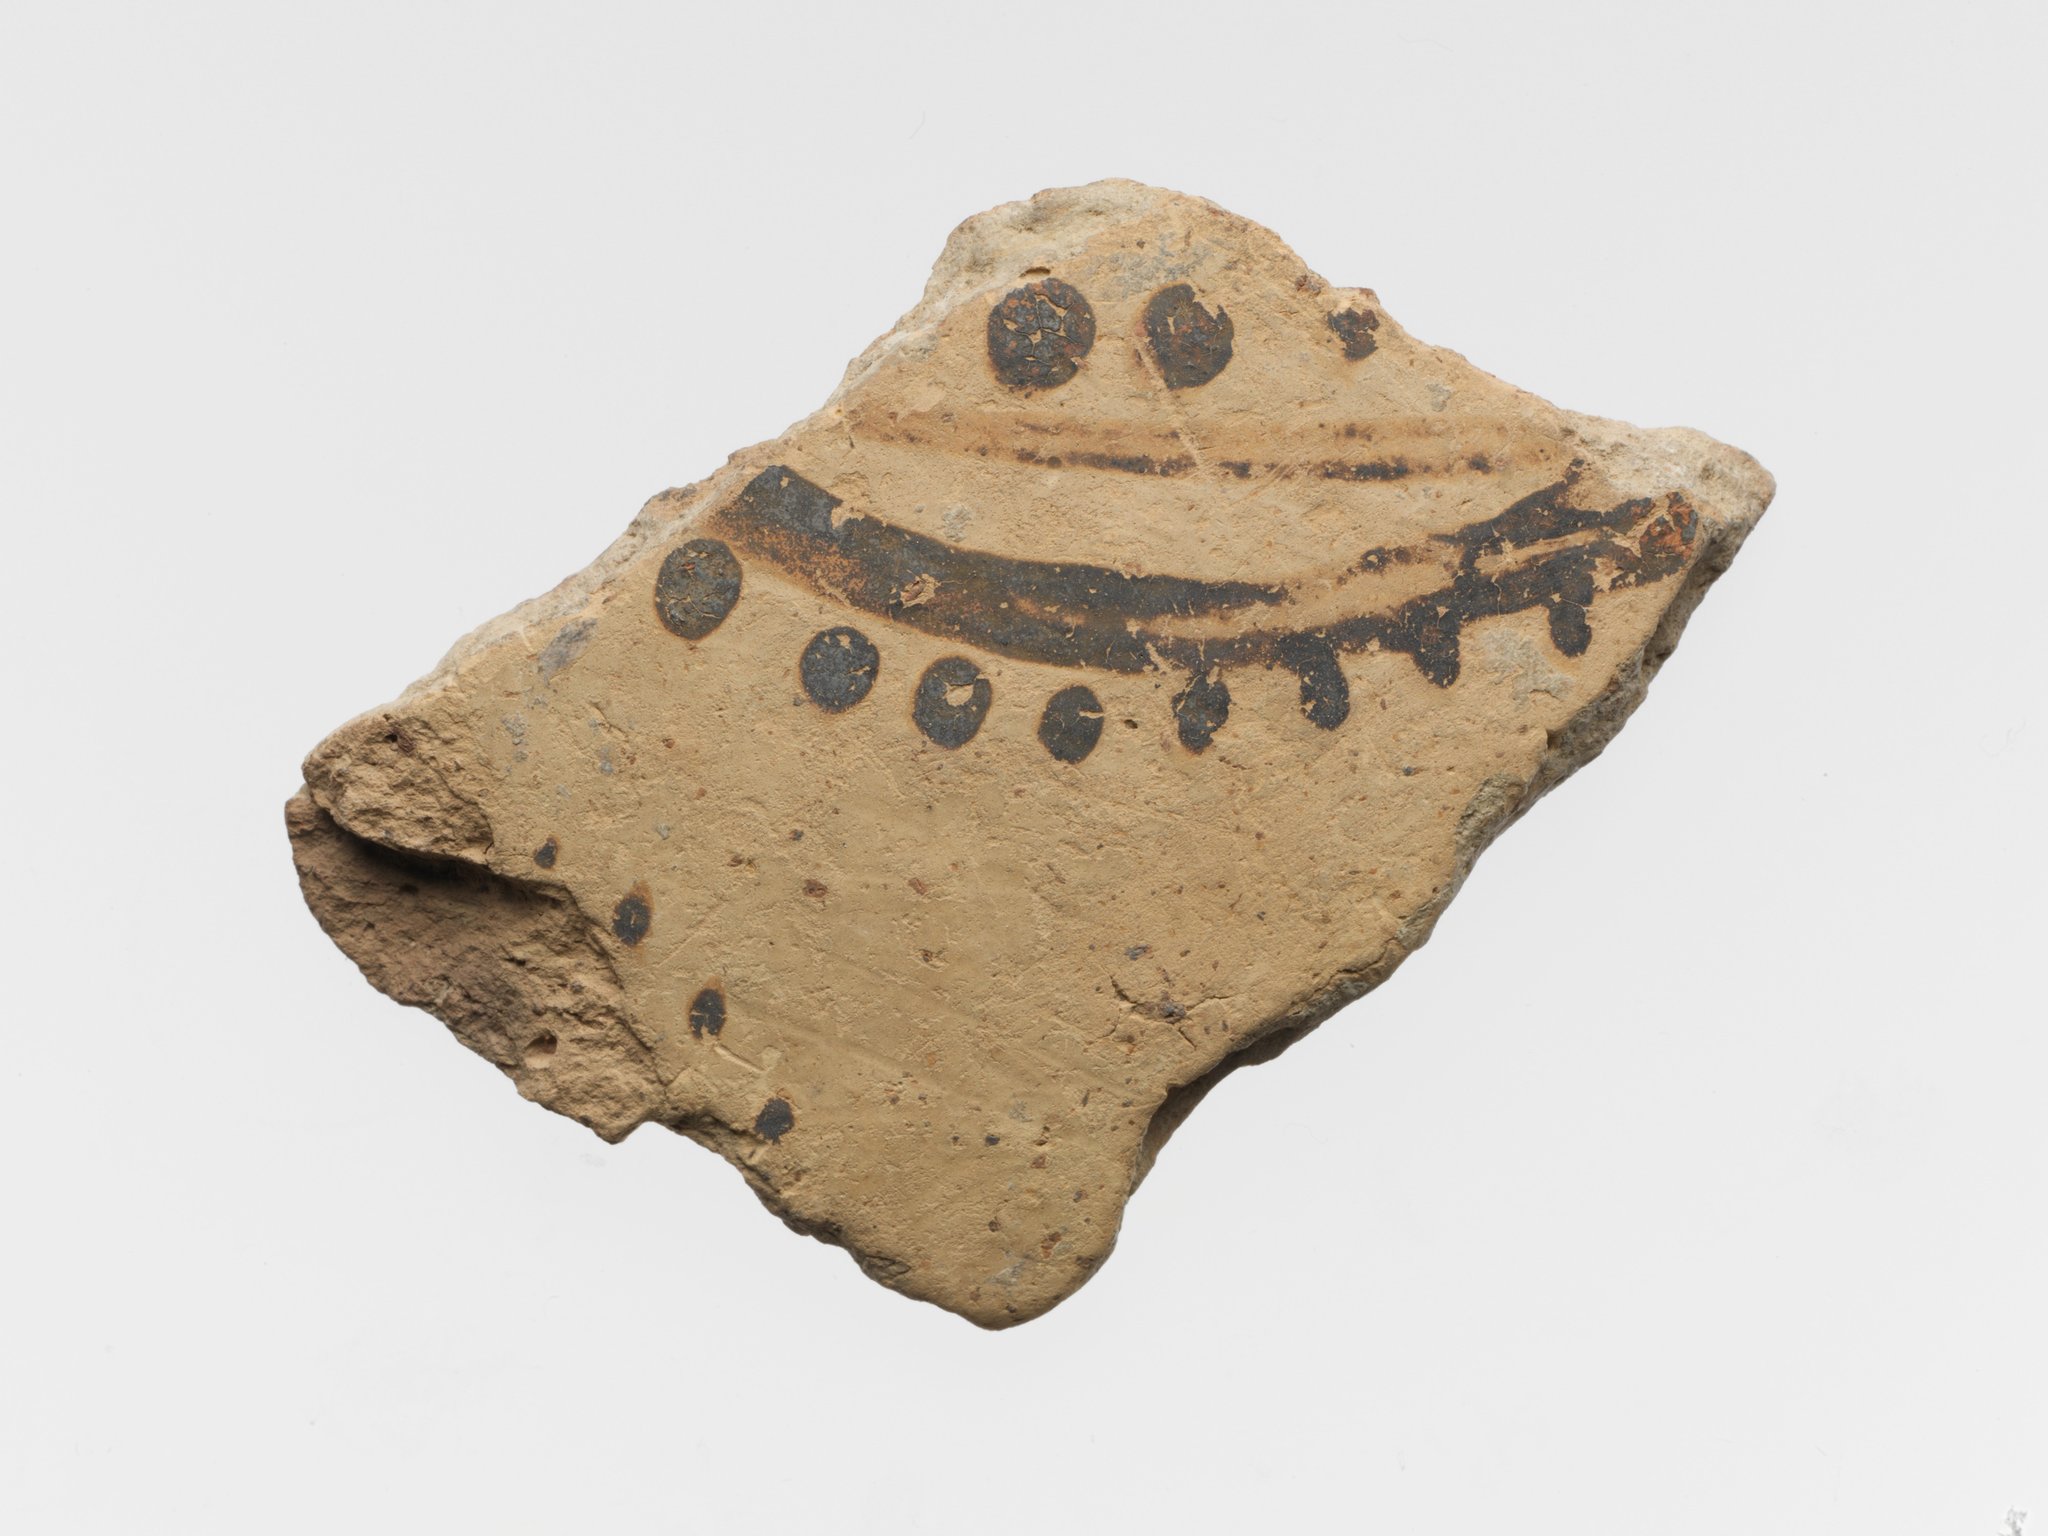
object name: vase fragment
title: Terracotta vessel fragment with floral or marine motif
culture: minoan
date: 1600-1450 BCE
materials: terracotta